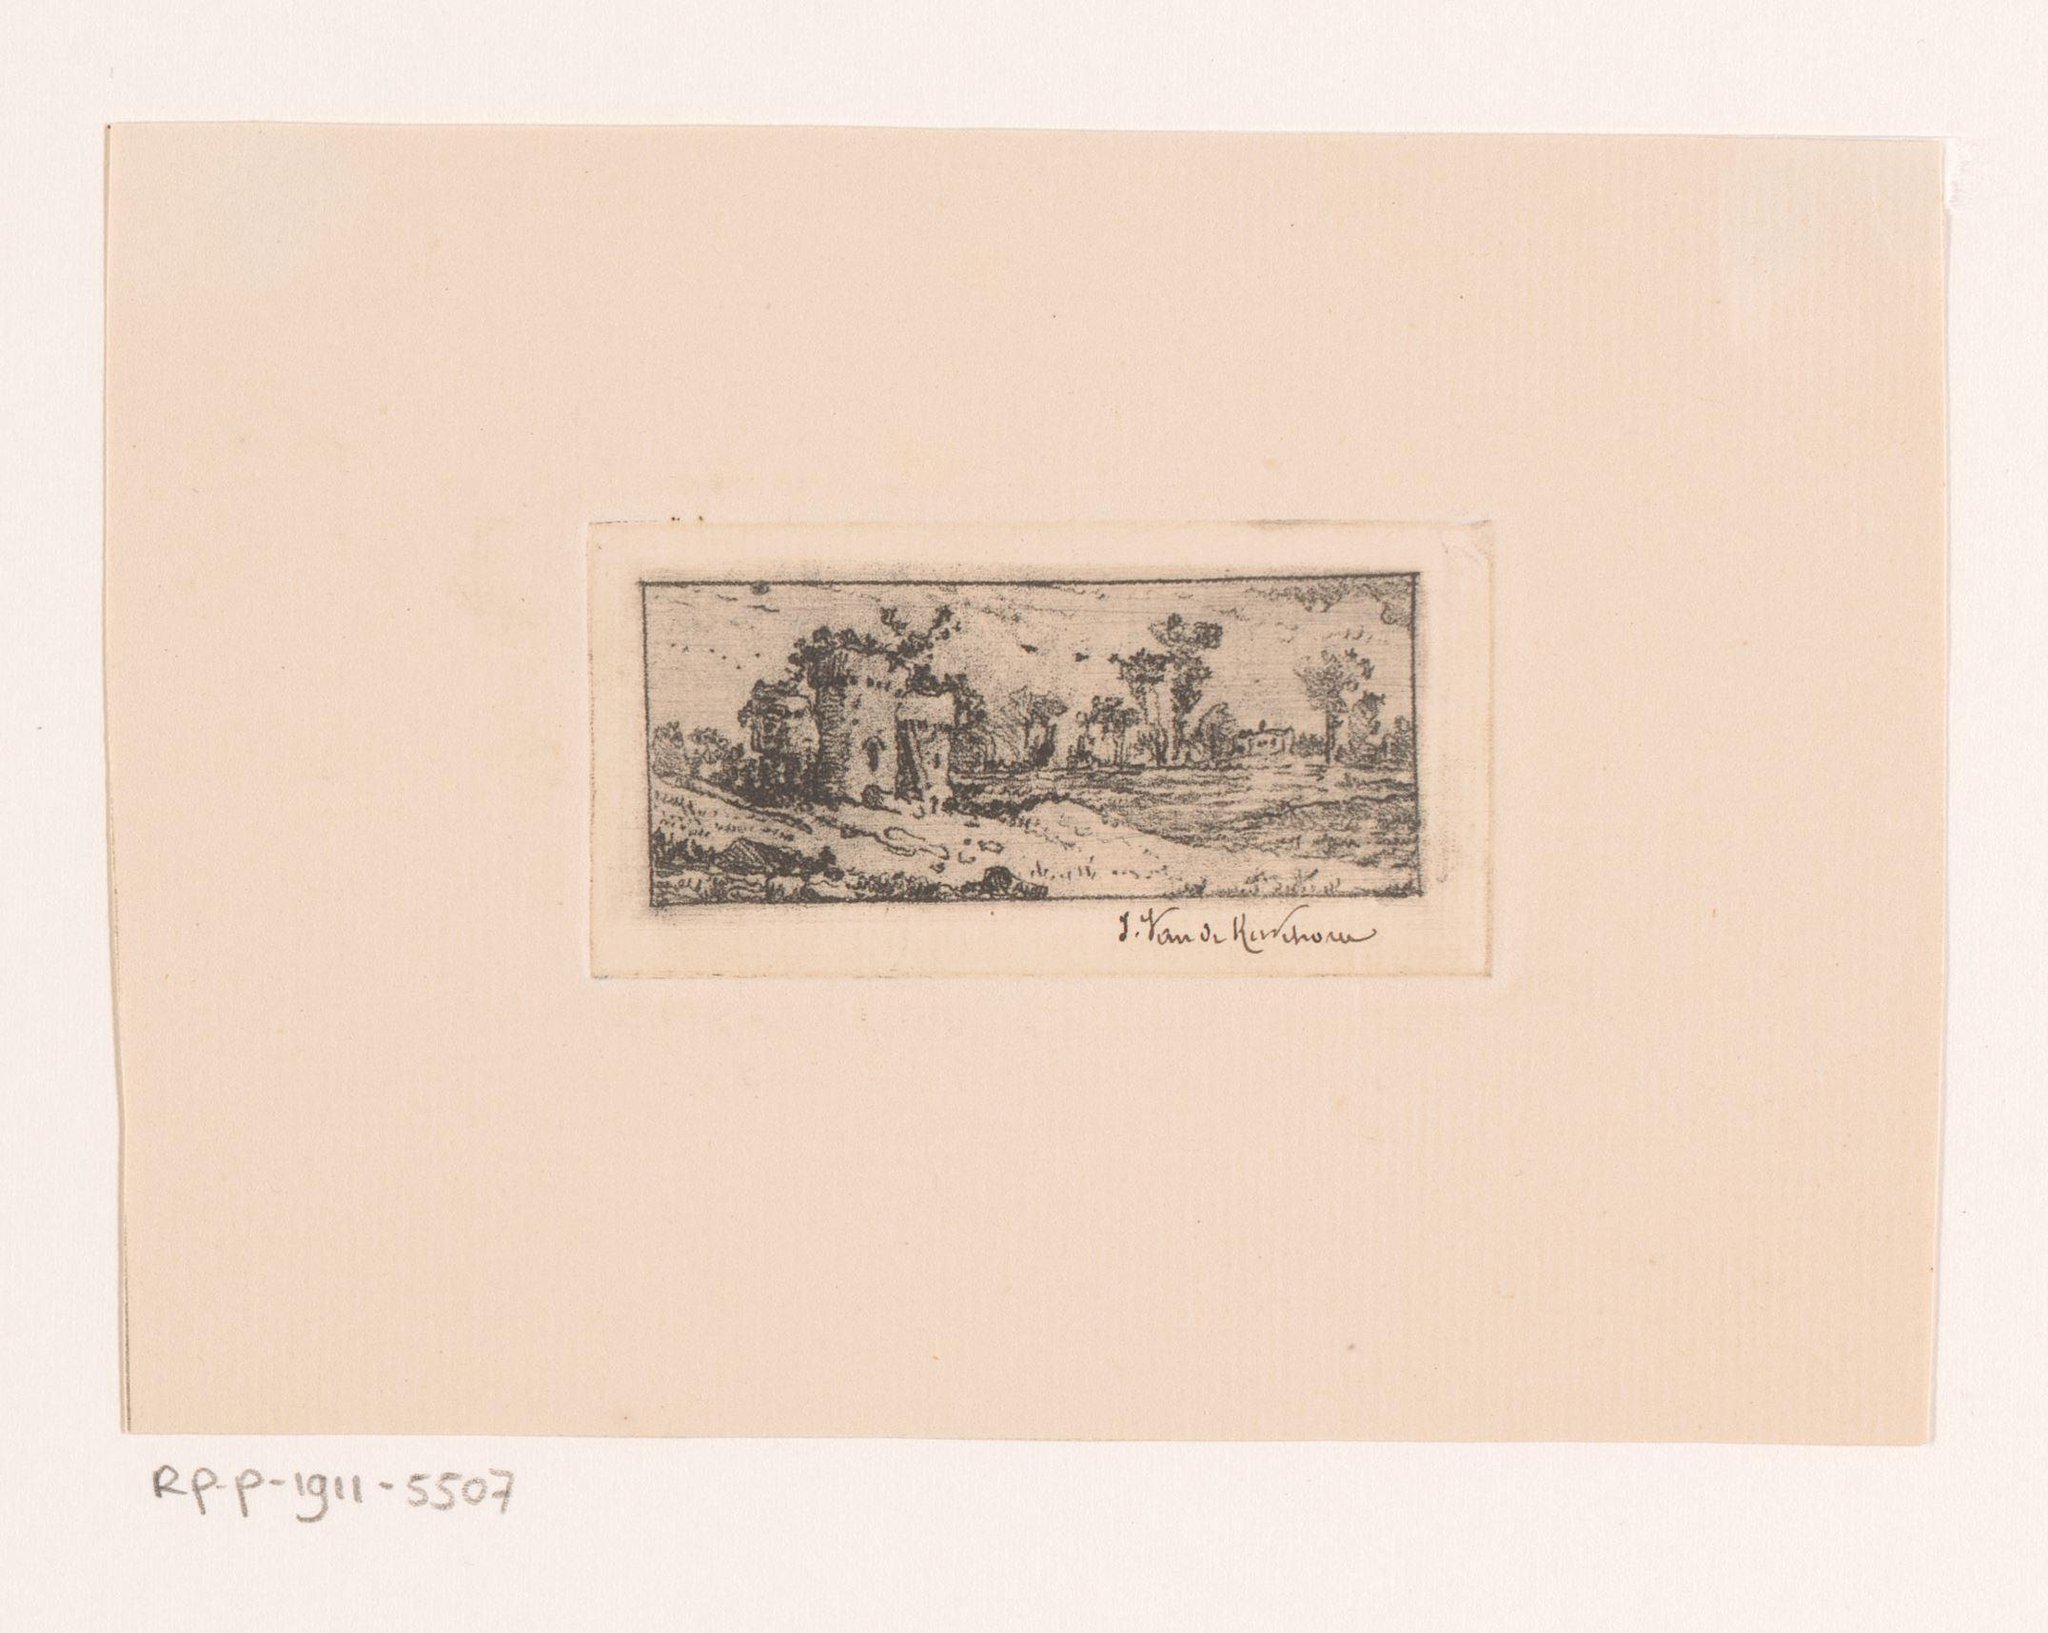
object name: print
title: Landschap met kasteelruïne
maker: jan van de kerkhove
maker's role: print maker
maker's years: 1822-1881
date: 1832-1881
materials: paper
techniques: drypoint, etching, intaglio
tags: landscape with ruins, ruin of a dwelling, house, castle, etc.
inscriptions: collector's mark: Lugt 2228